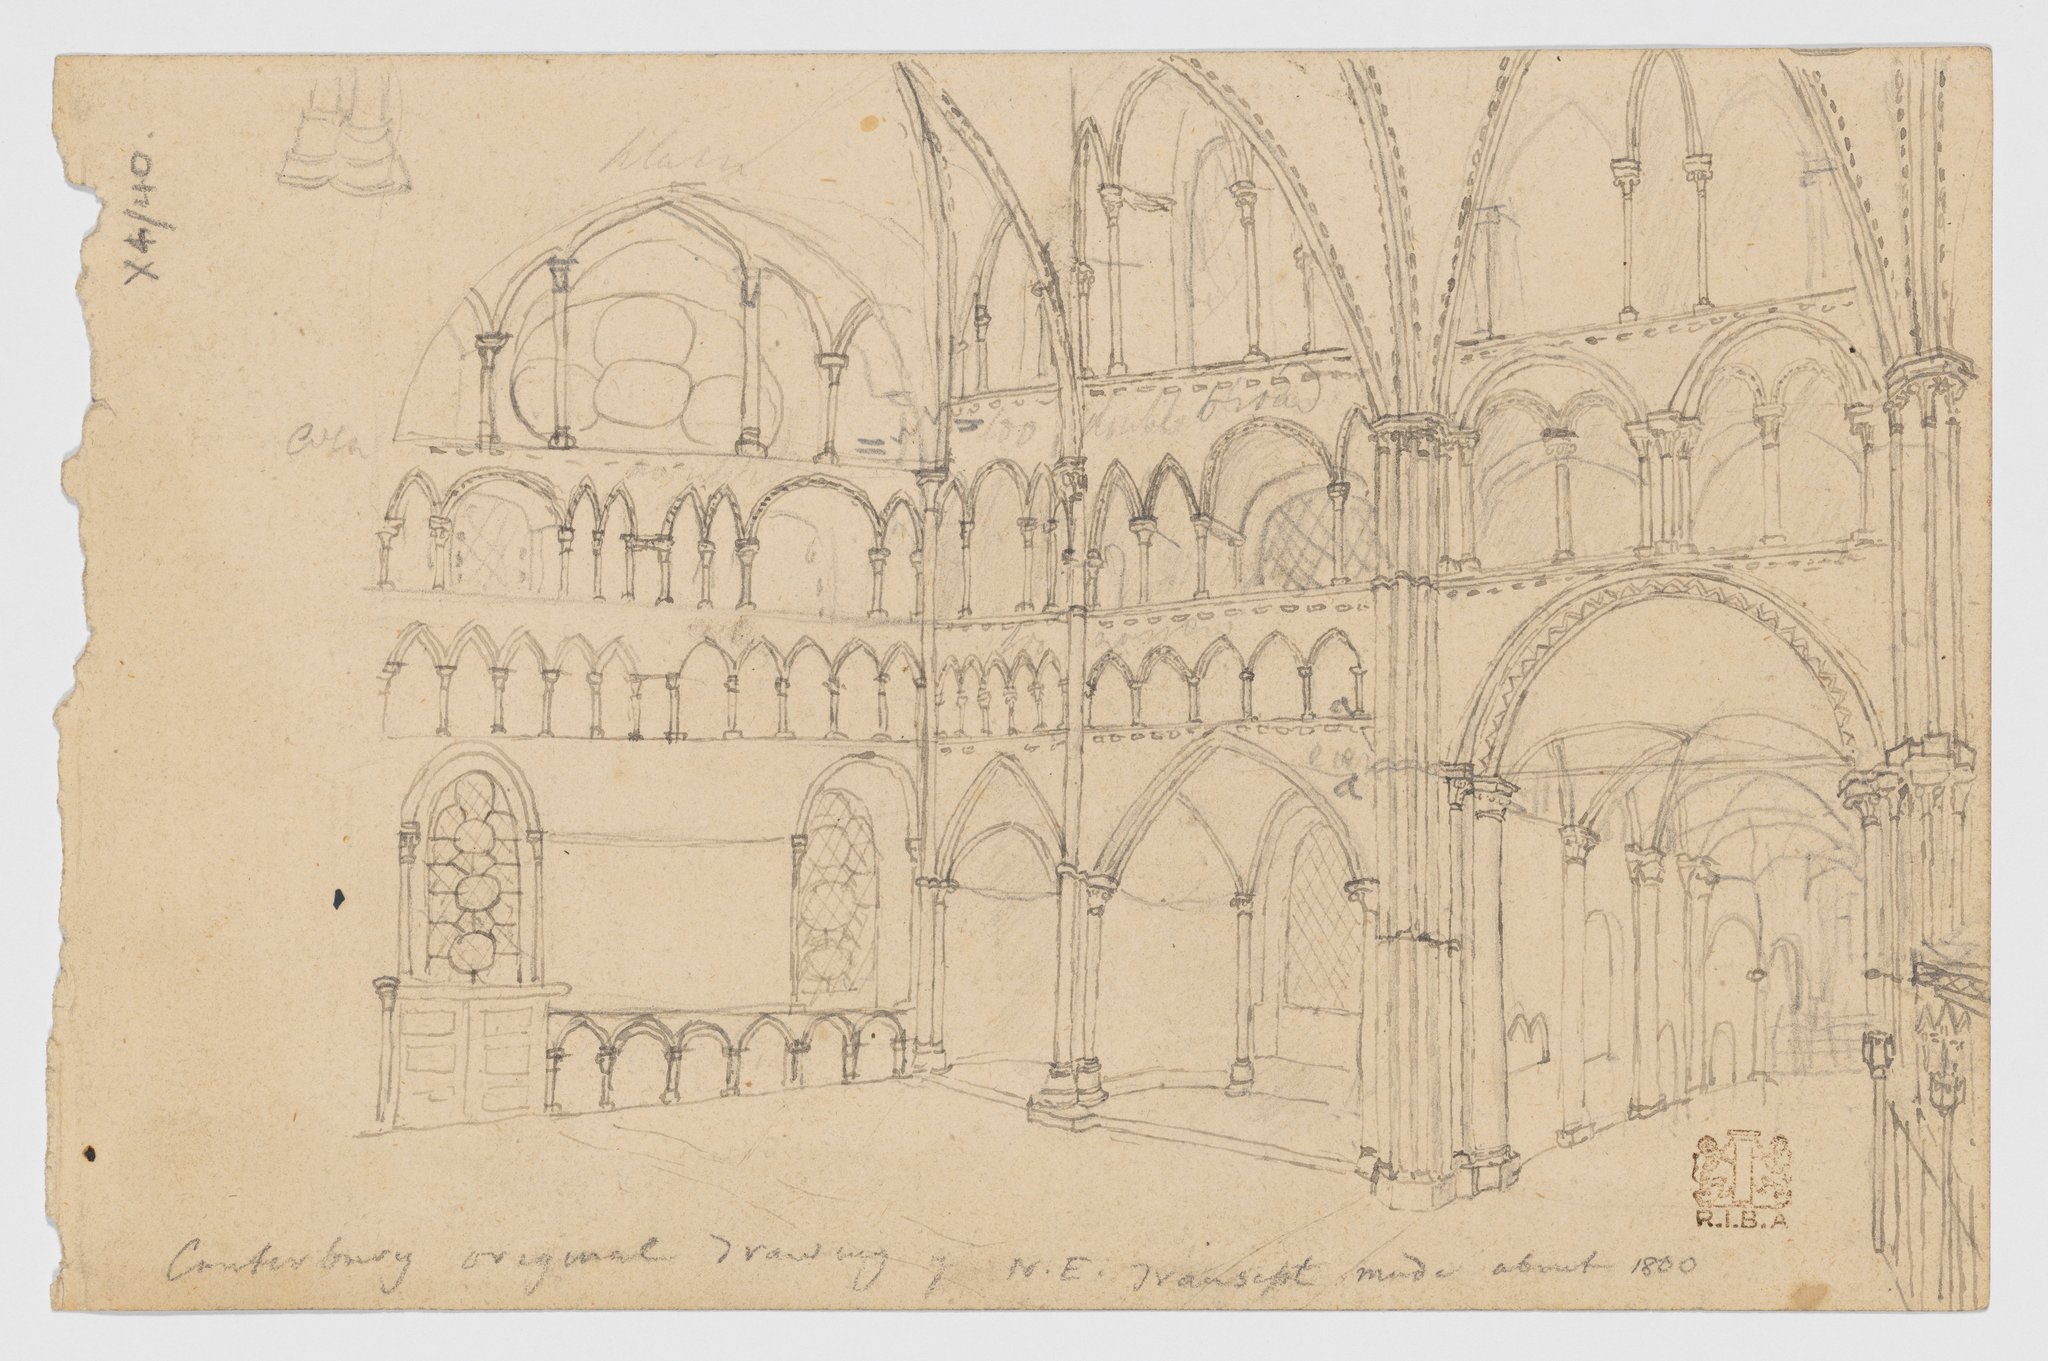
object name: drawing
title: Northeast Transept of Canterbury Cathedral (recto); Architectural Details (verso)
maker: anonymous, british, late 18th–early 19th century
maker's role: artist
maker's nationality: british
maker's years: 1771-1835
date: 1800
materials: graphite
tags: architecture,cathedrals